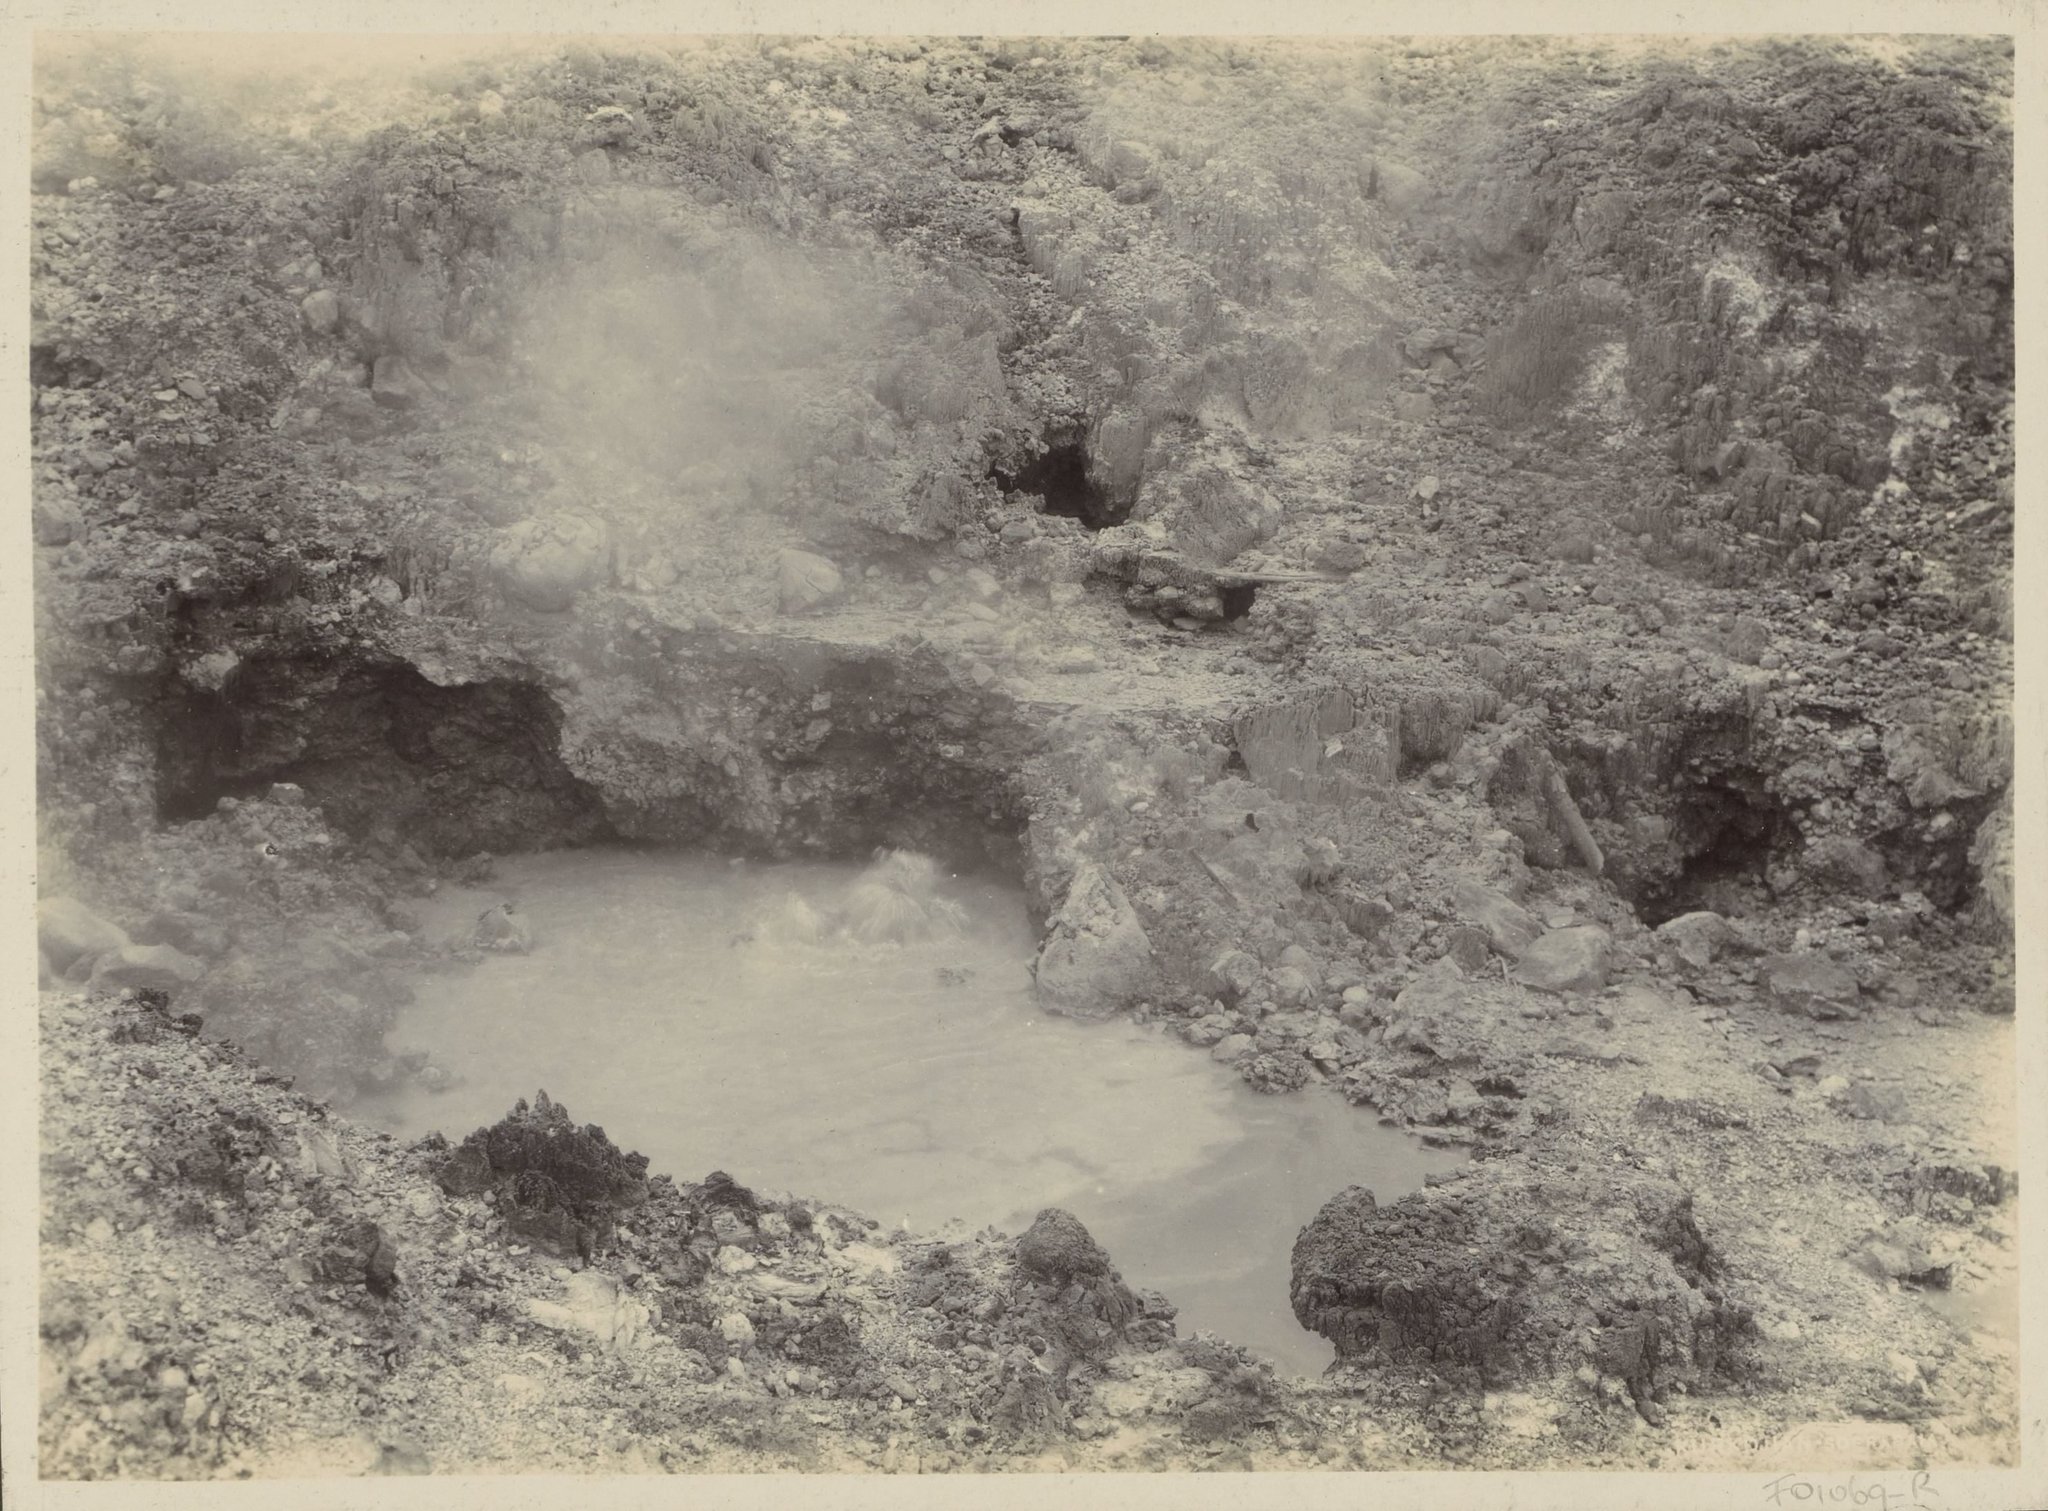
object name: photograph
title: Natuurlijke bron temidden van steen in Nederlands-Indië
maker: onnes kurkdjian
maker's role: fotograaf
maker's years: 1851-1903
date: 1912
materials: paper, photographic support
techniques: gelatin silver print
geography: dutch east indies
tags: spring (fluids extracted from the earth), dutch east indies, the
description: Onderdeel van Reisalbum met veertig foto's van Nederlands-Indië.